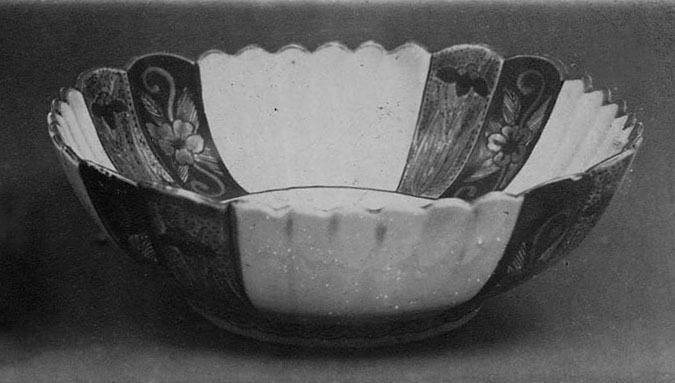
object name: dish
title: Vegetable Dish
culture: japanese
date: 1800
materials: enamel, porcelain